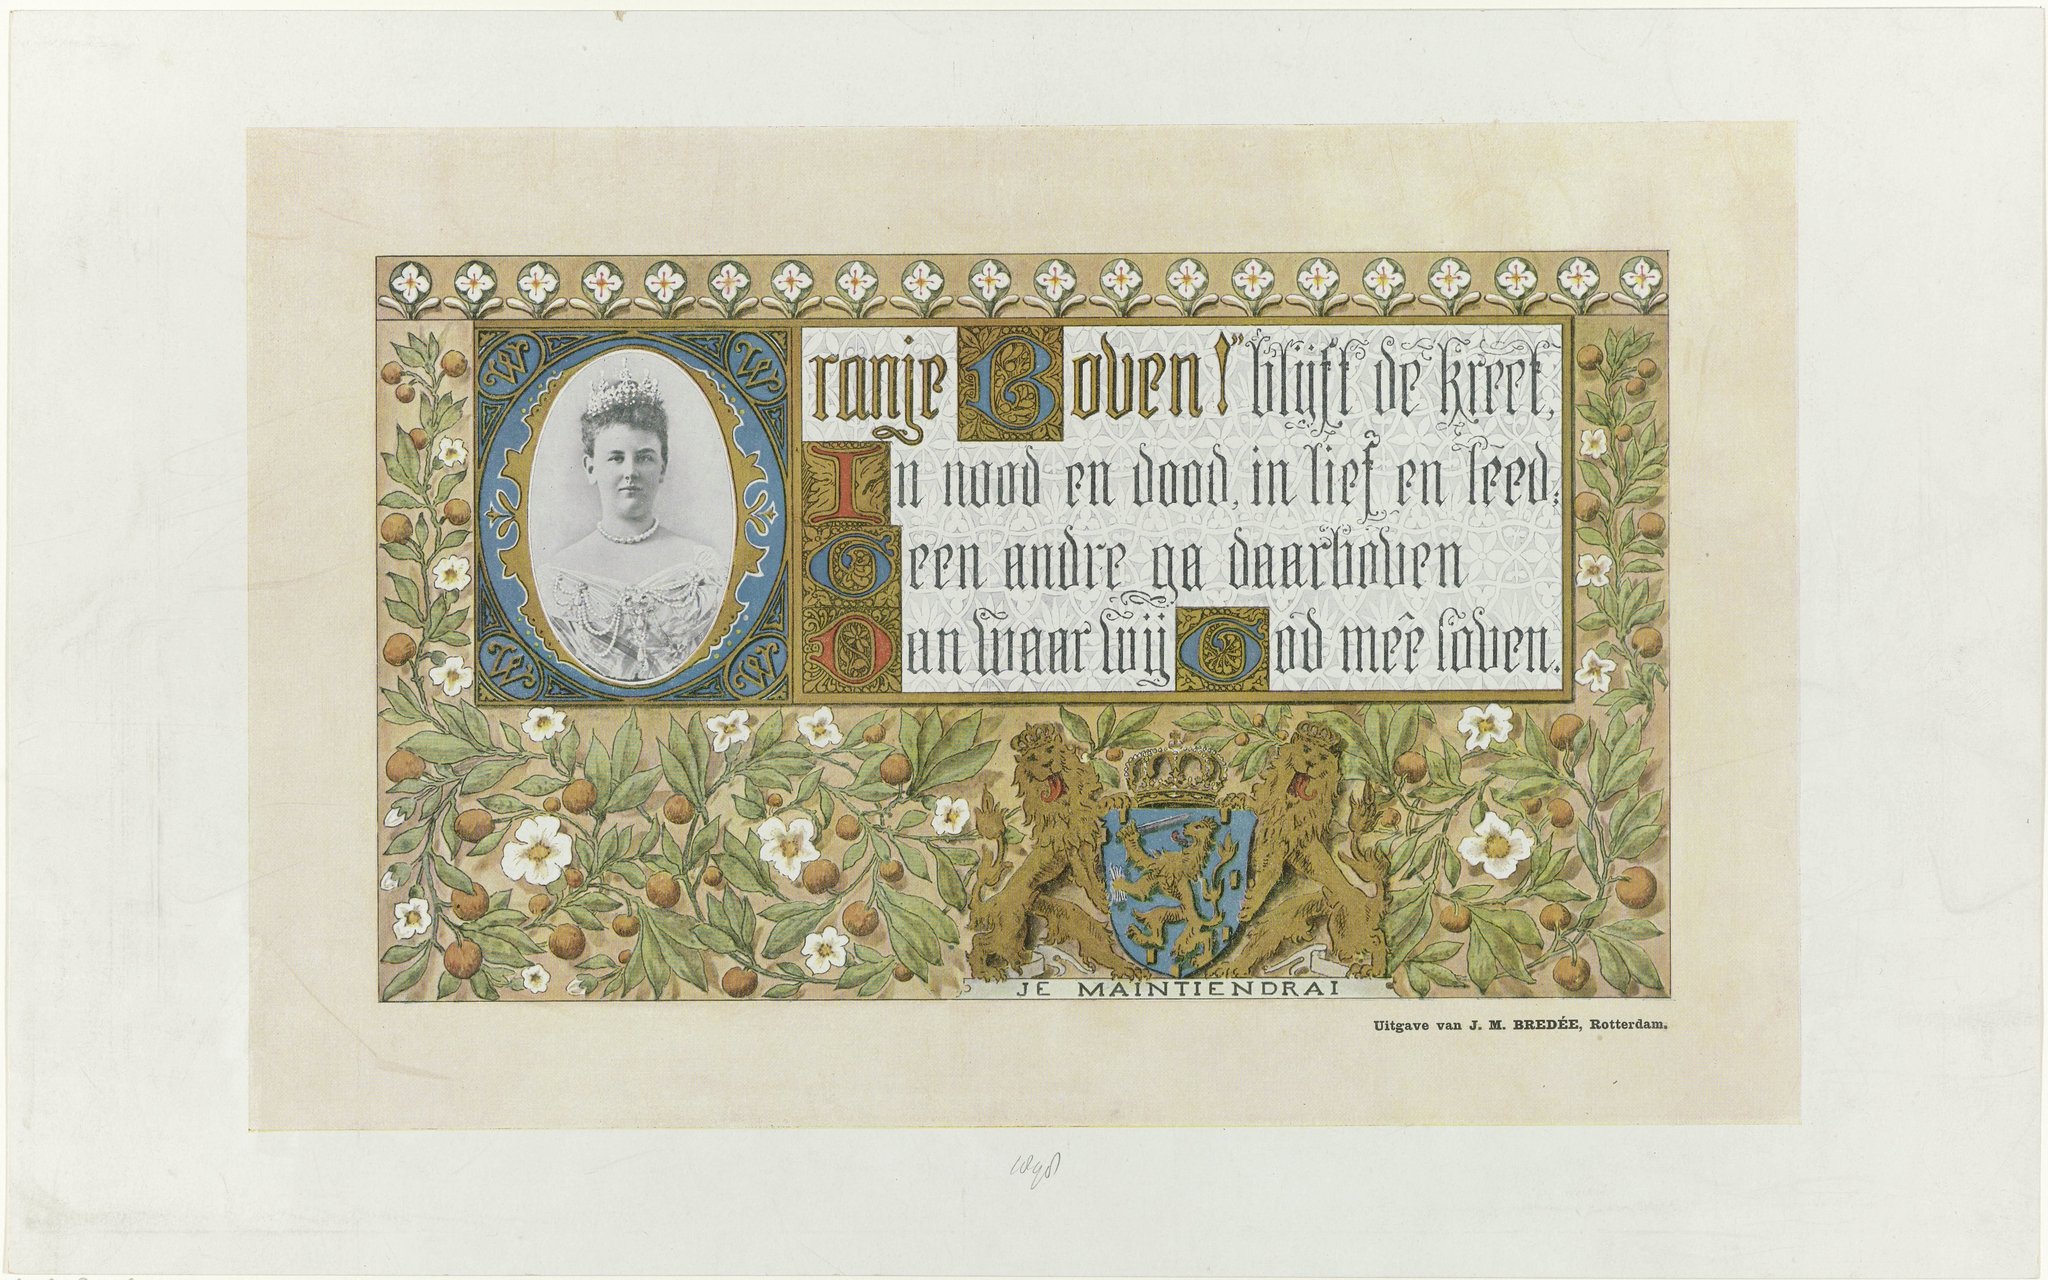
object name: photomechanical print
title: Portret van Wilhelmina, koningin der Nederlanden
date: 1898-1900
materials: paper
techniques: autotype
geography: rotterdam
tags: the hague, print maker, wilhelmina of the netherlands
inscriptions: collector's mark: Lugt 2228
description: Portret van Wilhelmina in een geornamenteerd ovaal dat tevens de eerste letter is van vier regels Nederlandse tekst in een kader. Daar omheen takken van een oranjeboom met bladeren, bloesem en vruchten. Midden onder een wapen met een kroon en twee leeuwen.